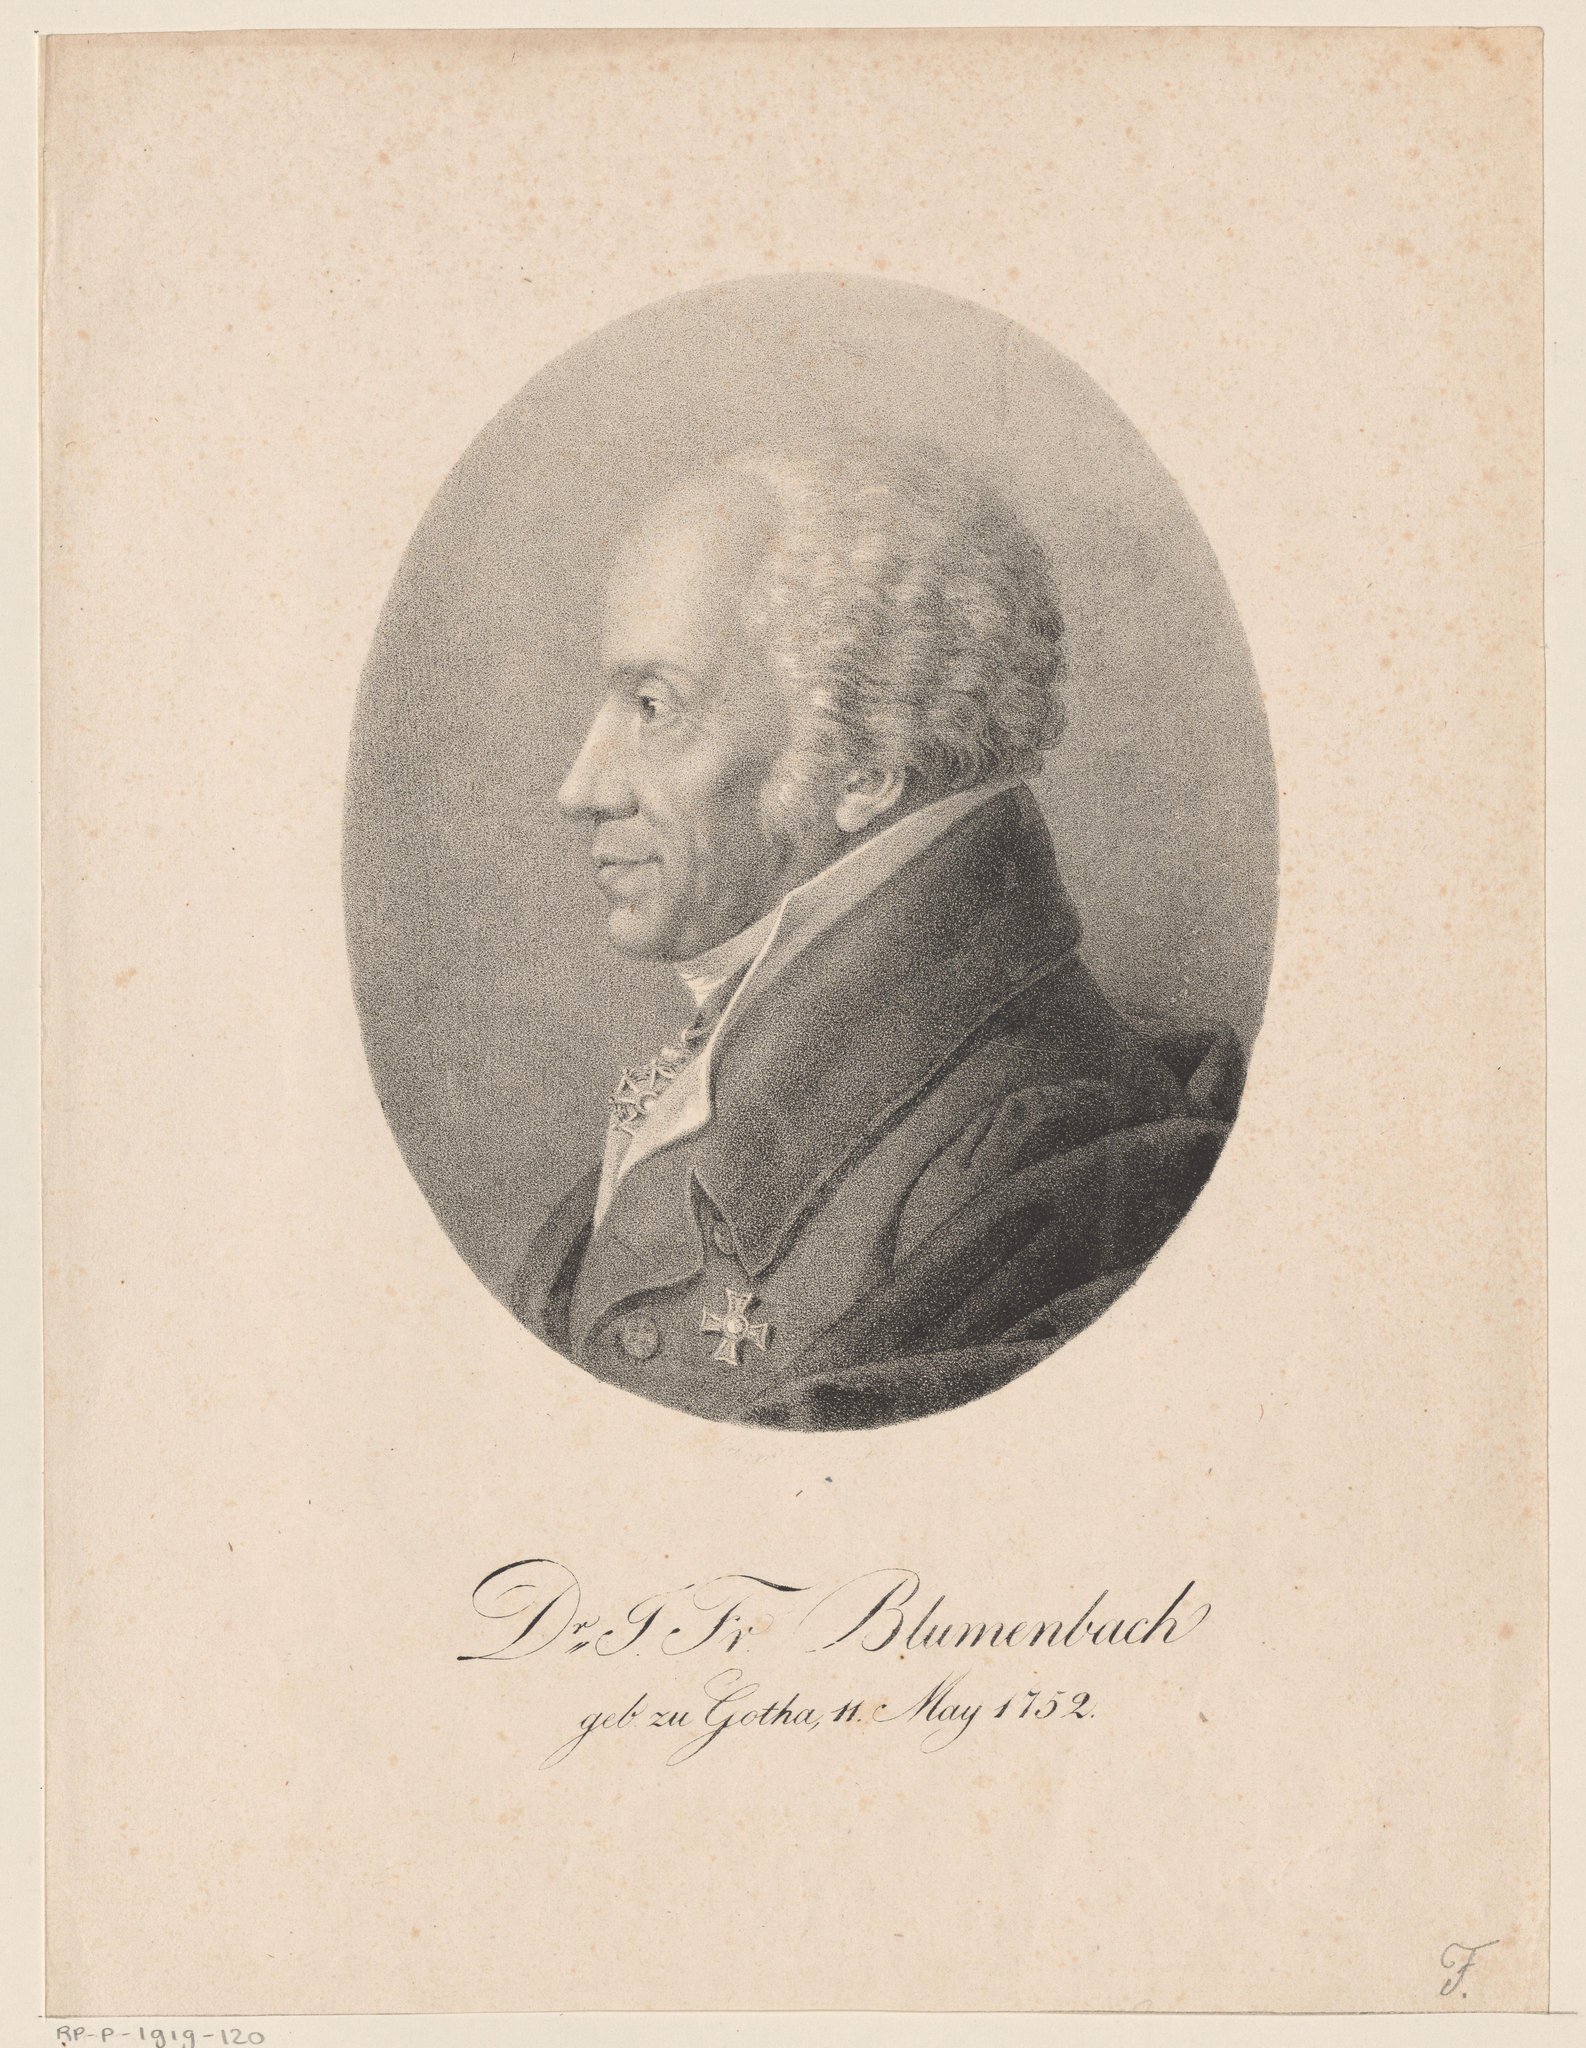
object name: print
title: Dr. J. Fr. Blumenbach (...)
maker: Anonymous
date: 1800-1849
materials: paper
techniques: lithograph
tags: physicist, historical persons, physician, doctor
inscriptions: collector's mark: Lugt 2228